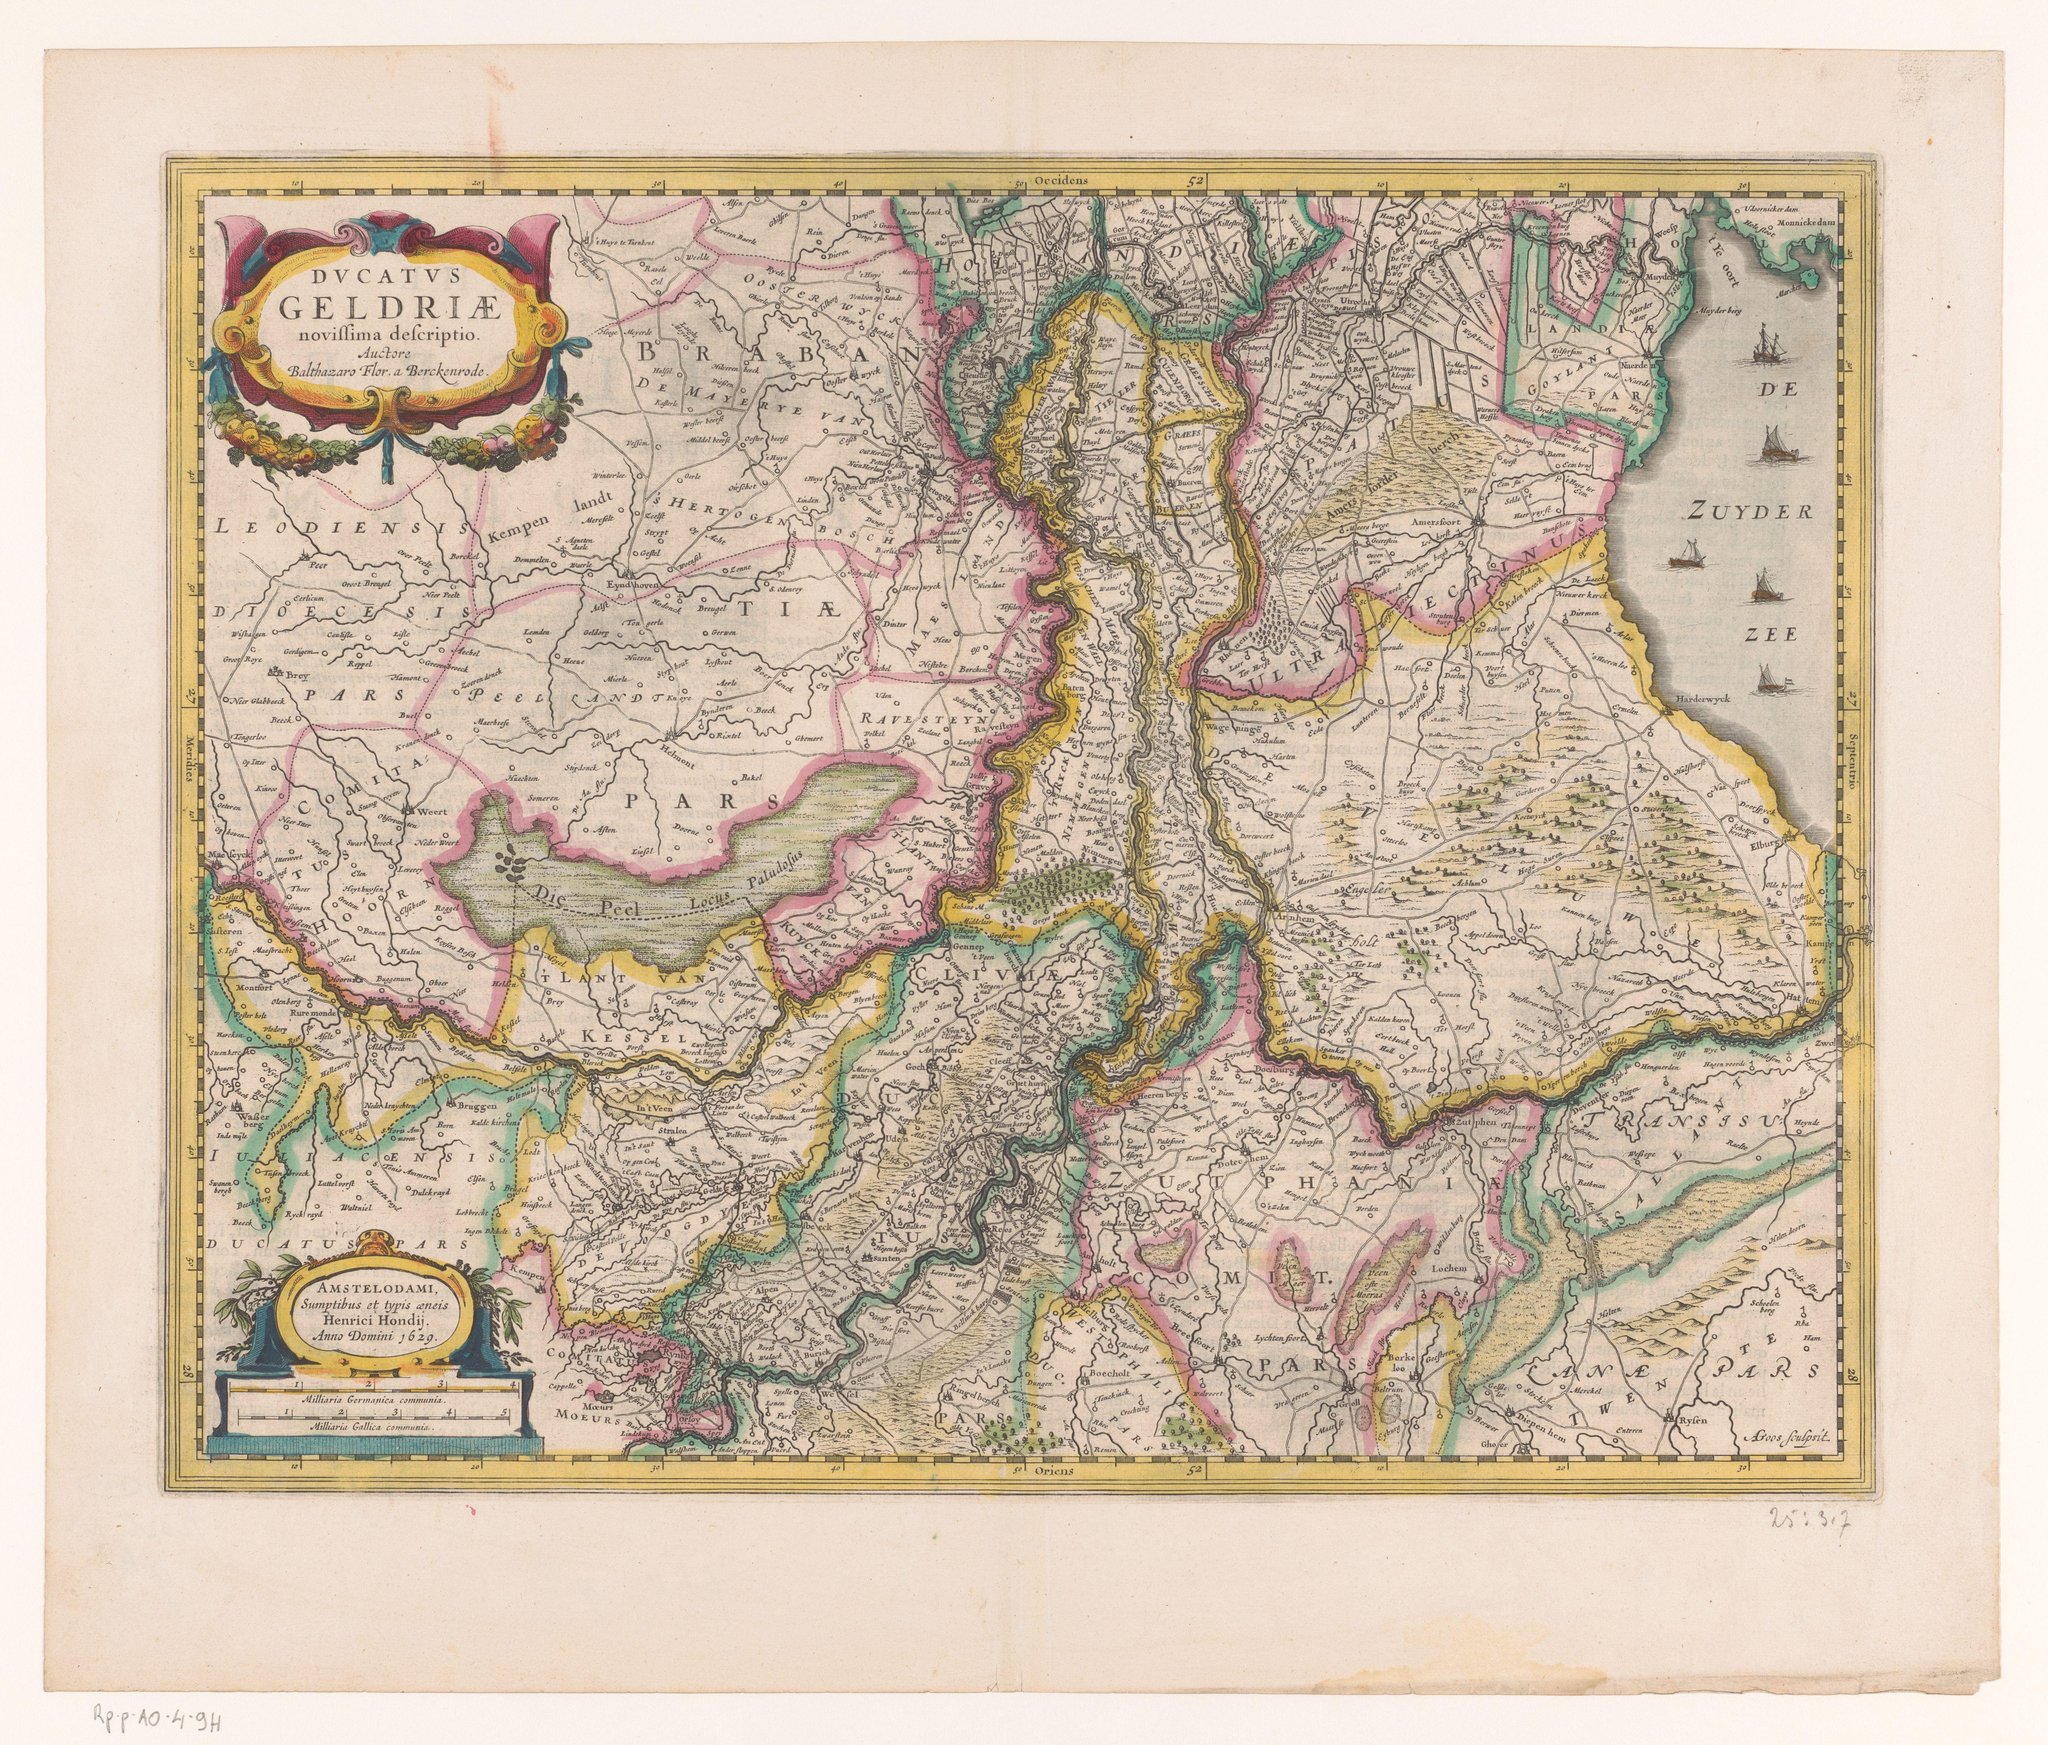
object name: print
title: Kaart van Gelderland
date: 1633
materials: paper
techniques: engraving, etching, hand coloring, letterpress printing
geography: amsterdam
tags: maps of separate countries or regions, gelderland, guelders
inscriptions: collector's mark: Lugt 2228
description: Linksboven de titelcartouche. Linksonder een cartouche met twee schaalstokken: 4 Milliaria Germanica communia / 5 Milliaria Gallica communia. De kaart is voorzien van een gradenverdeling langs de randen. Met Franse tekst op verso.